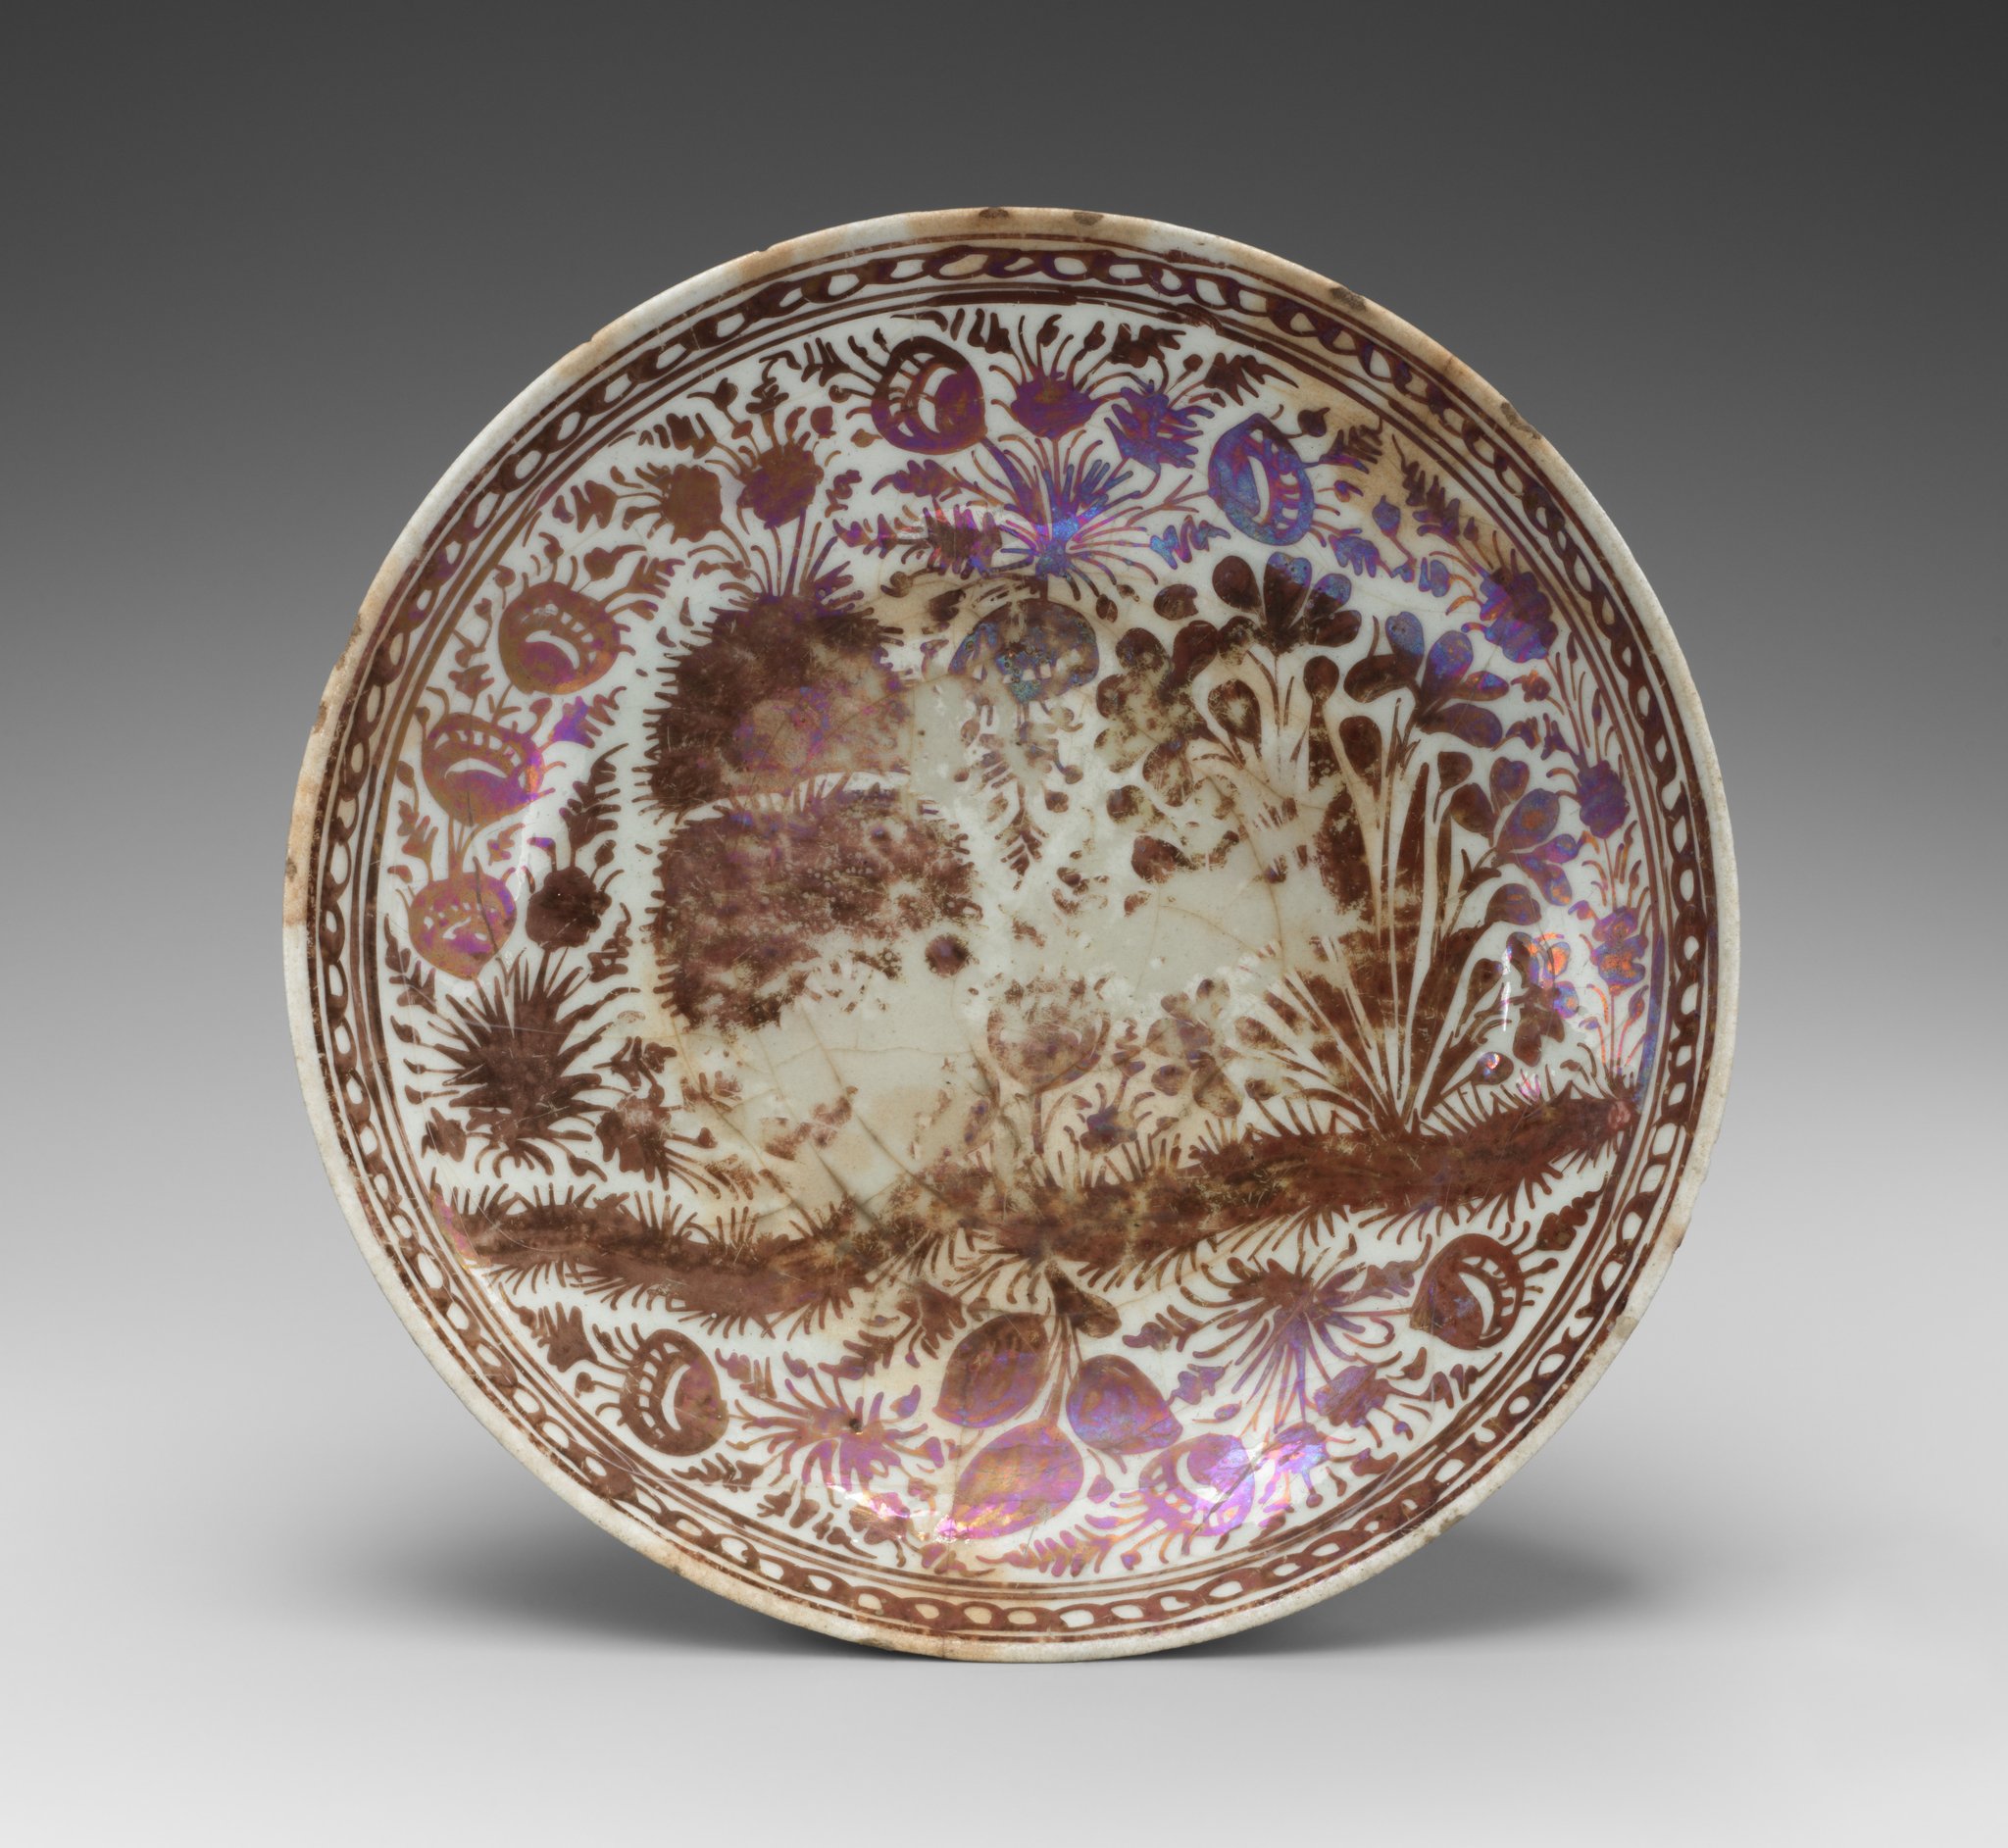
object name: plate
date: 1601-1700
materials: glaze, stonepaste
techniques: luster painting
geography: iran